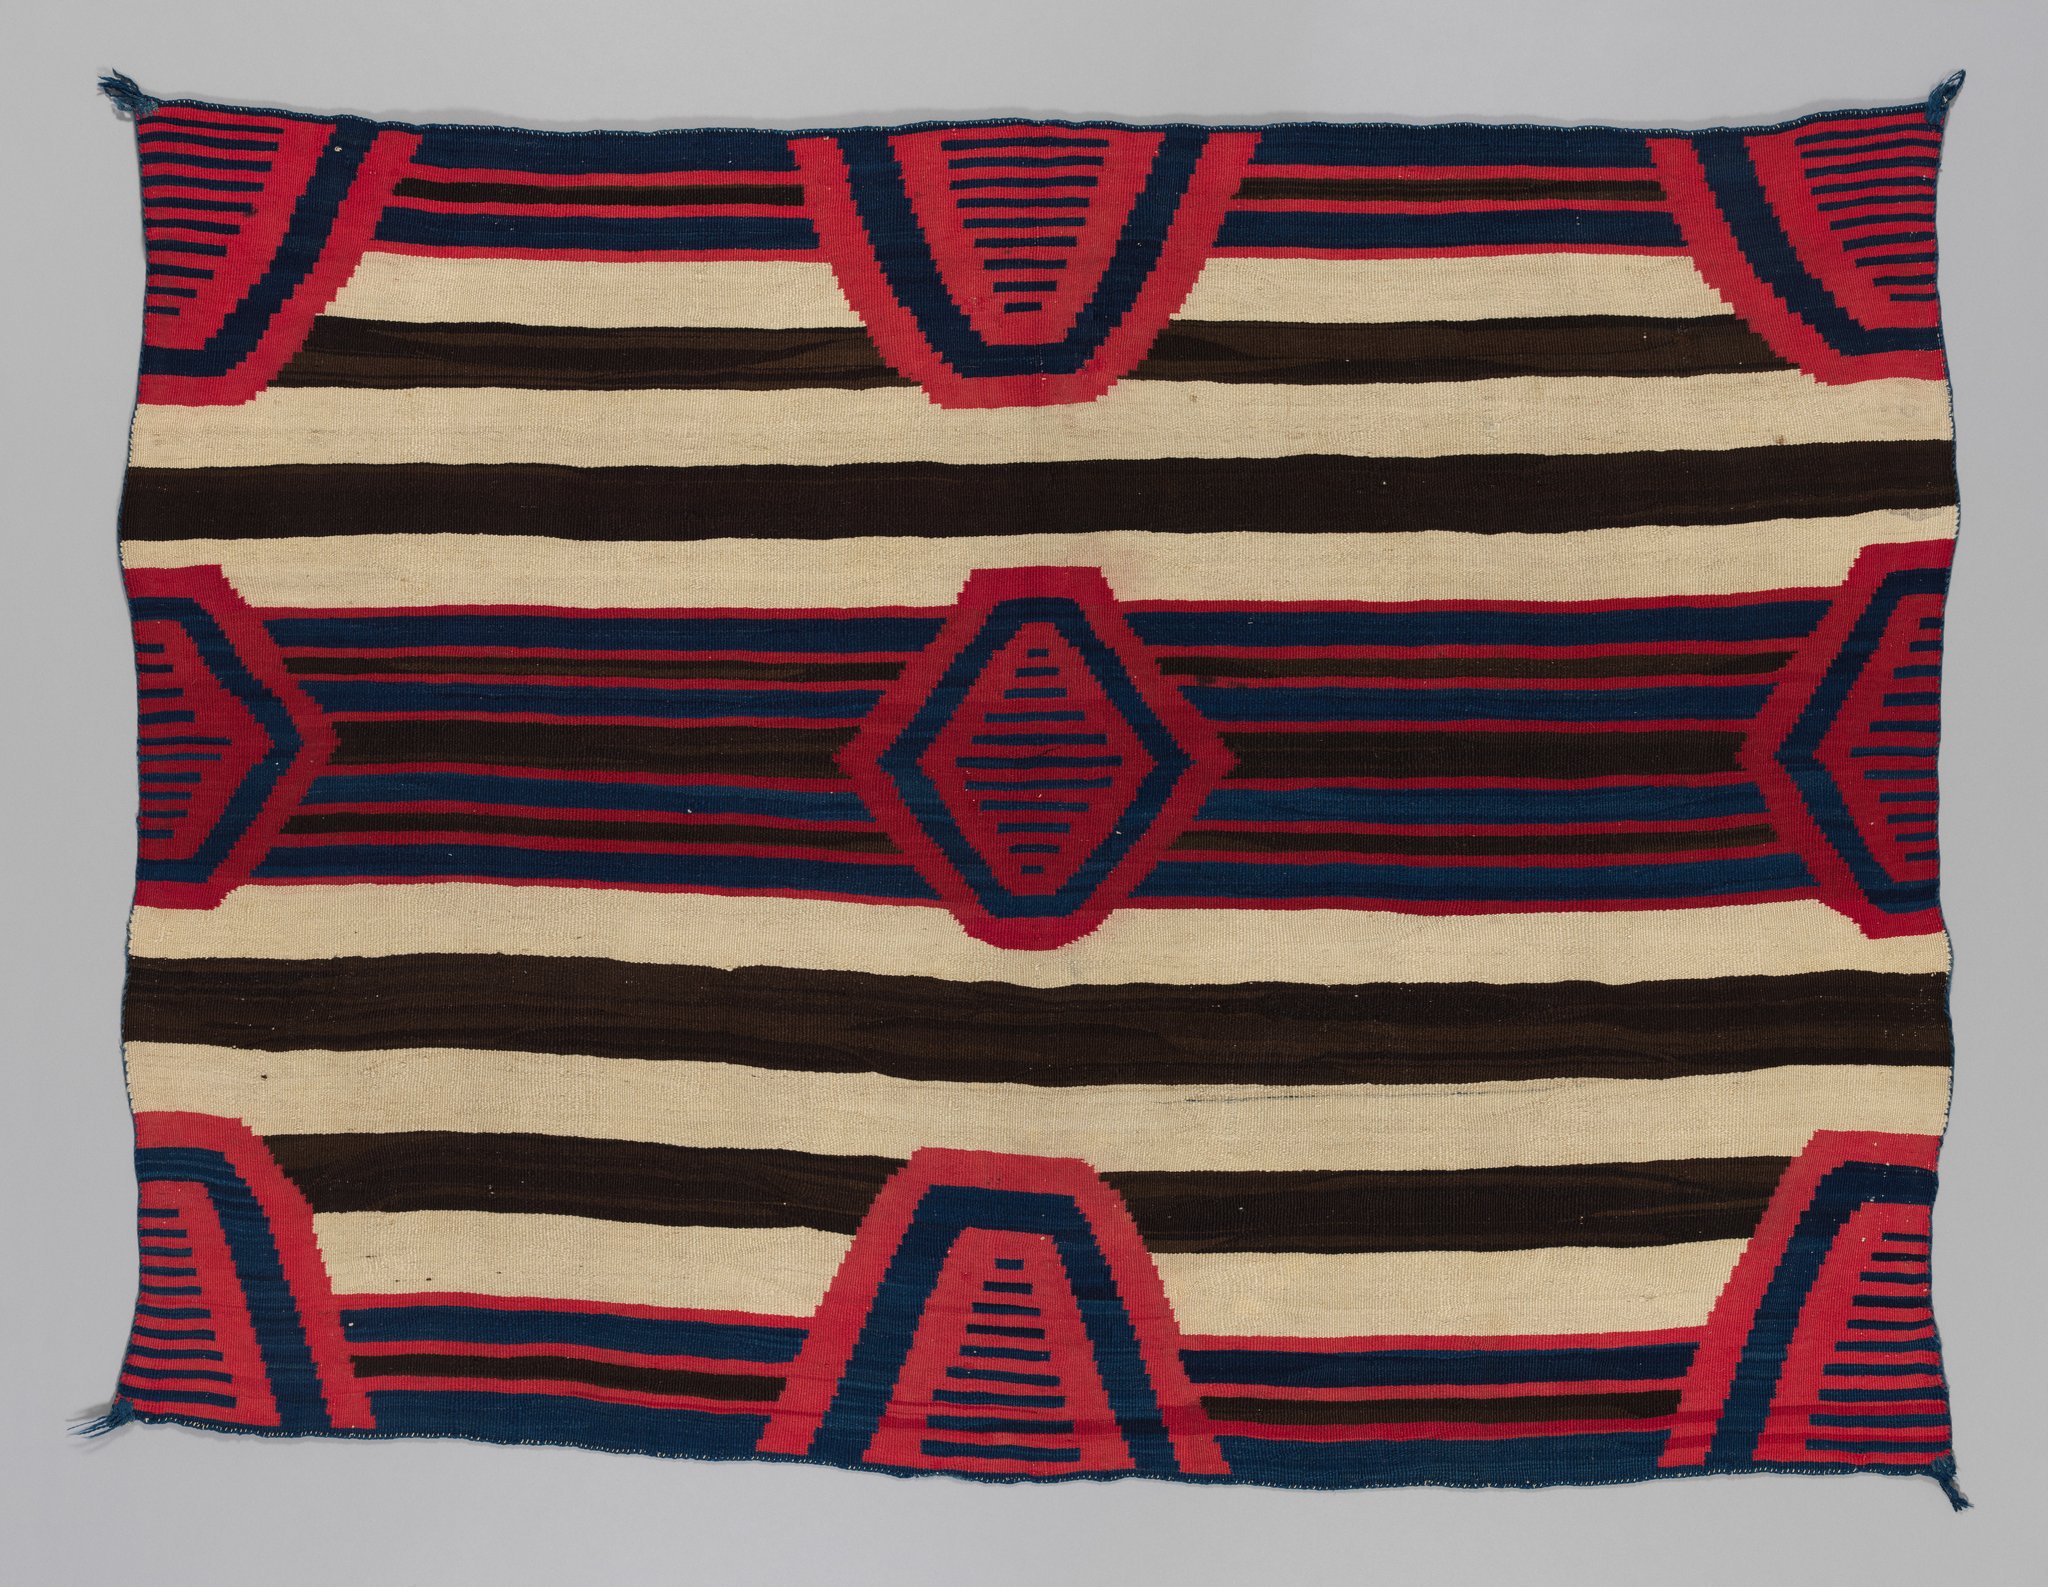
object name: blanket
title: Chief's blanket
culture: diné or navajo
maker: unidentified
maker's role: artist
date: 1865-1870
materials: wool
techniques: dyeing